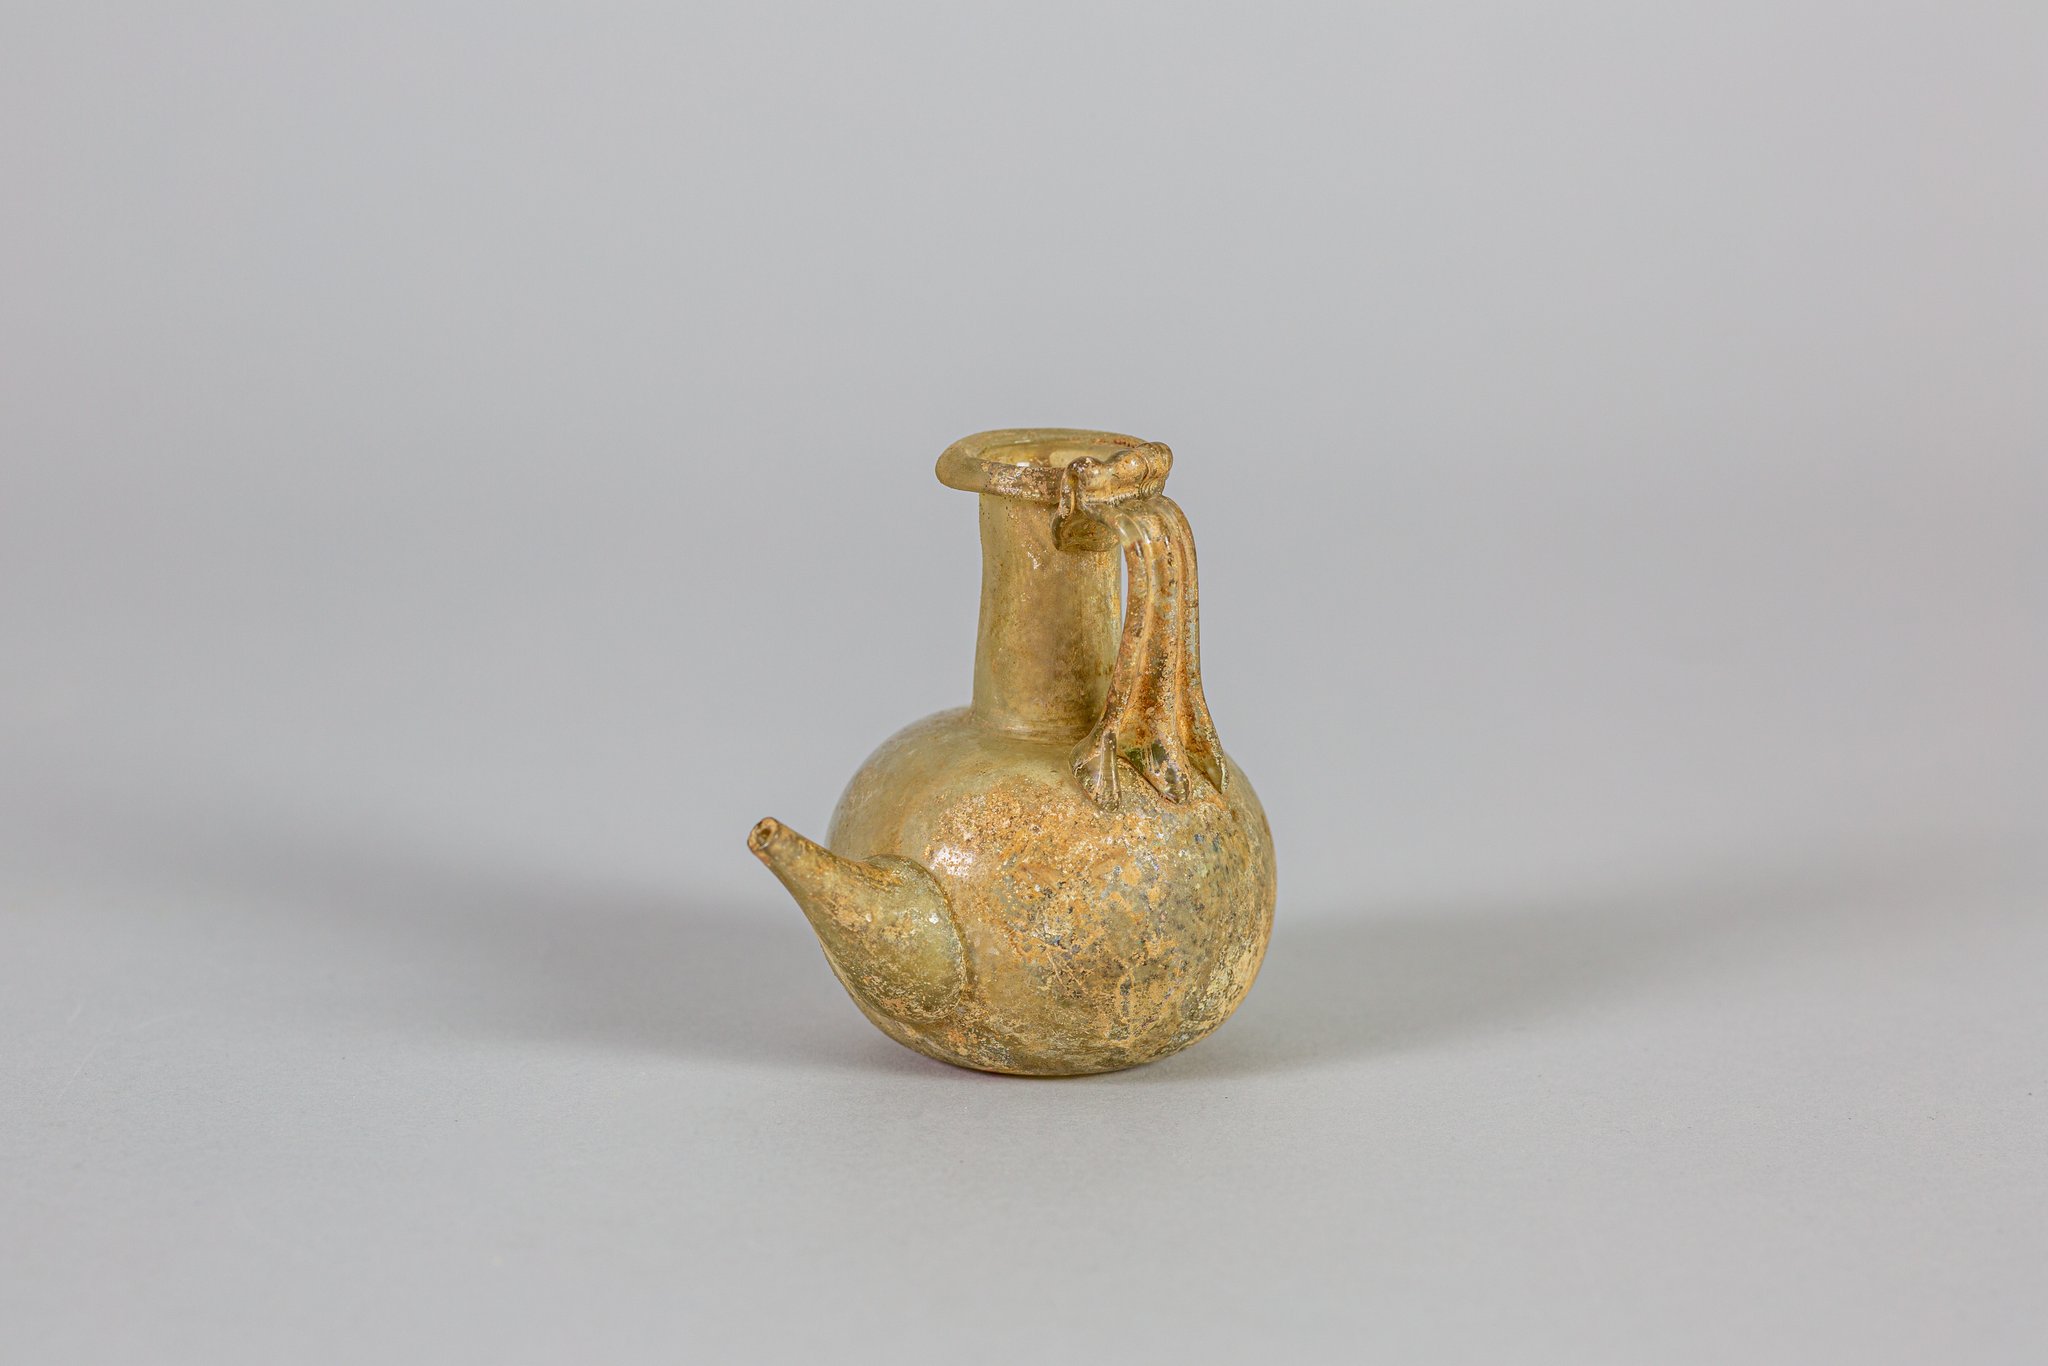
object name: jug, spouted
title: Glass jug with spout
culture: roman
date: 1-200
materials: glass